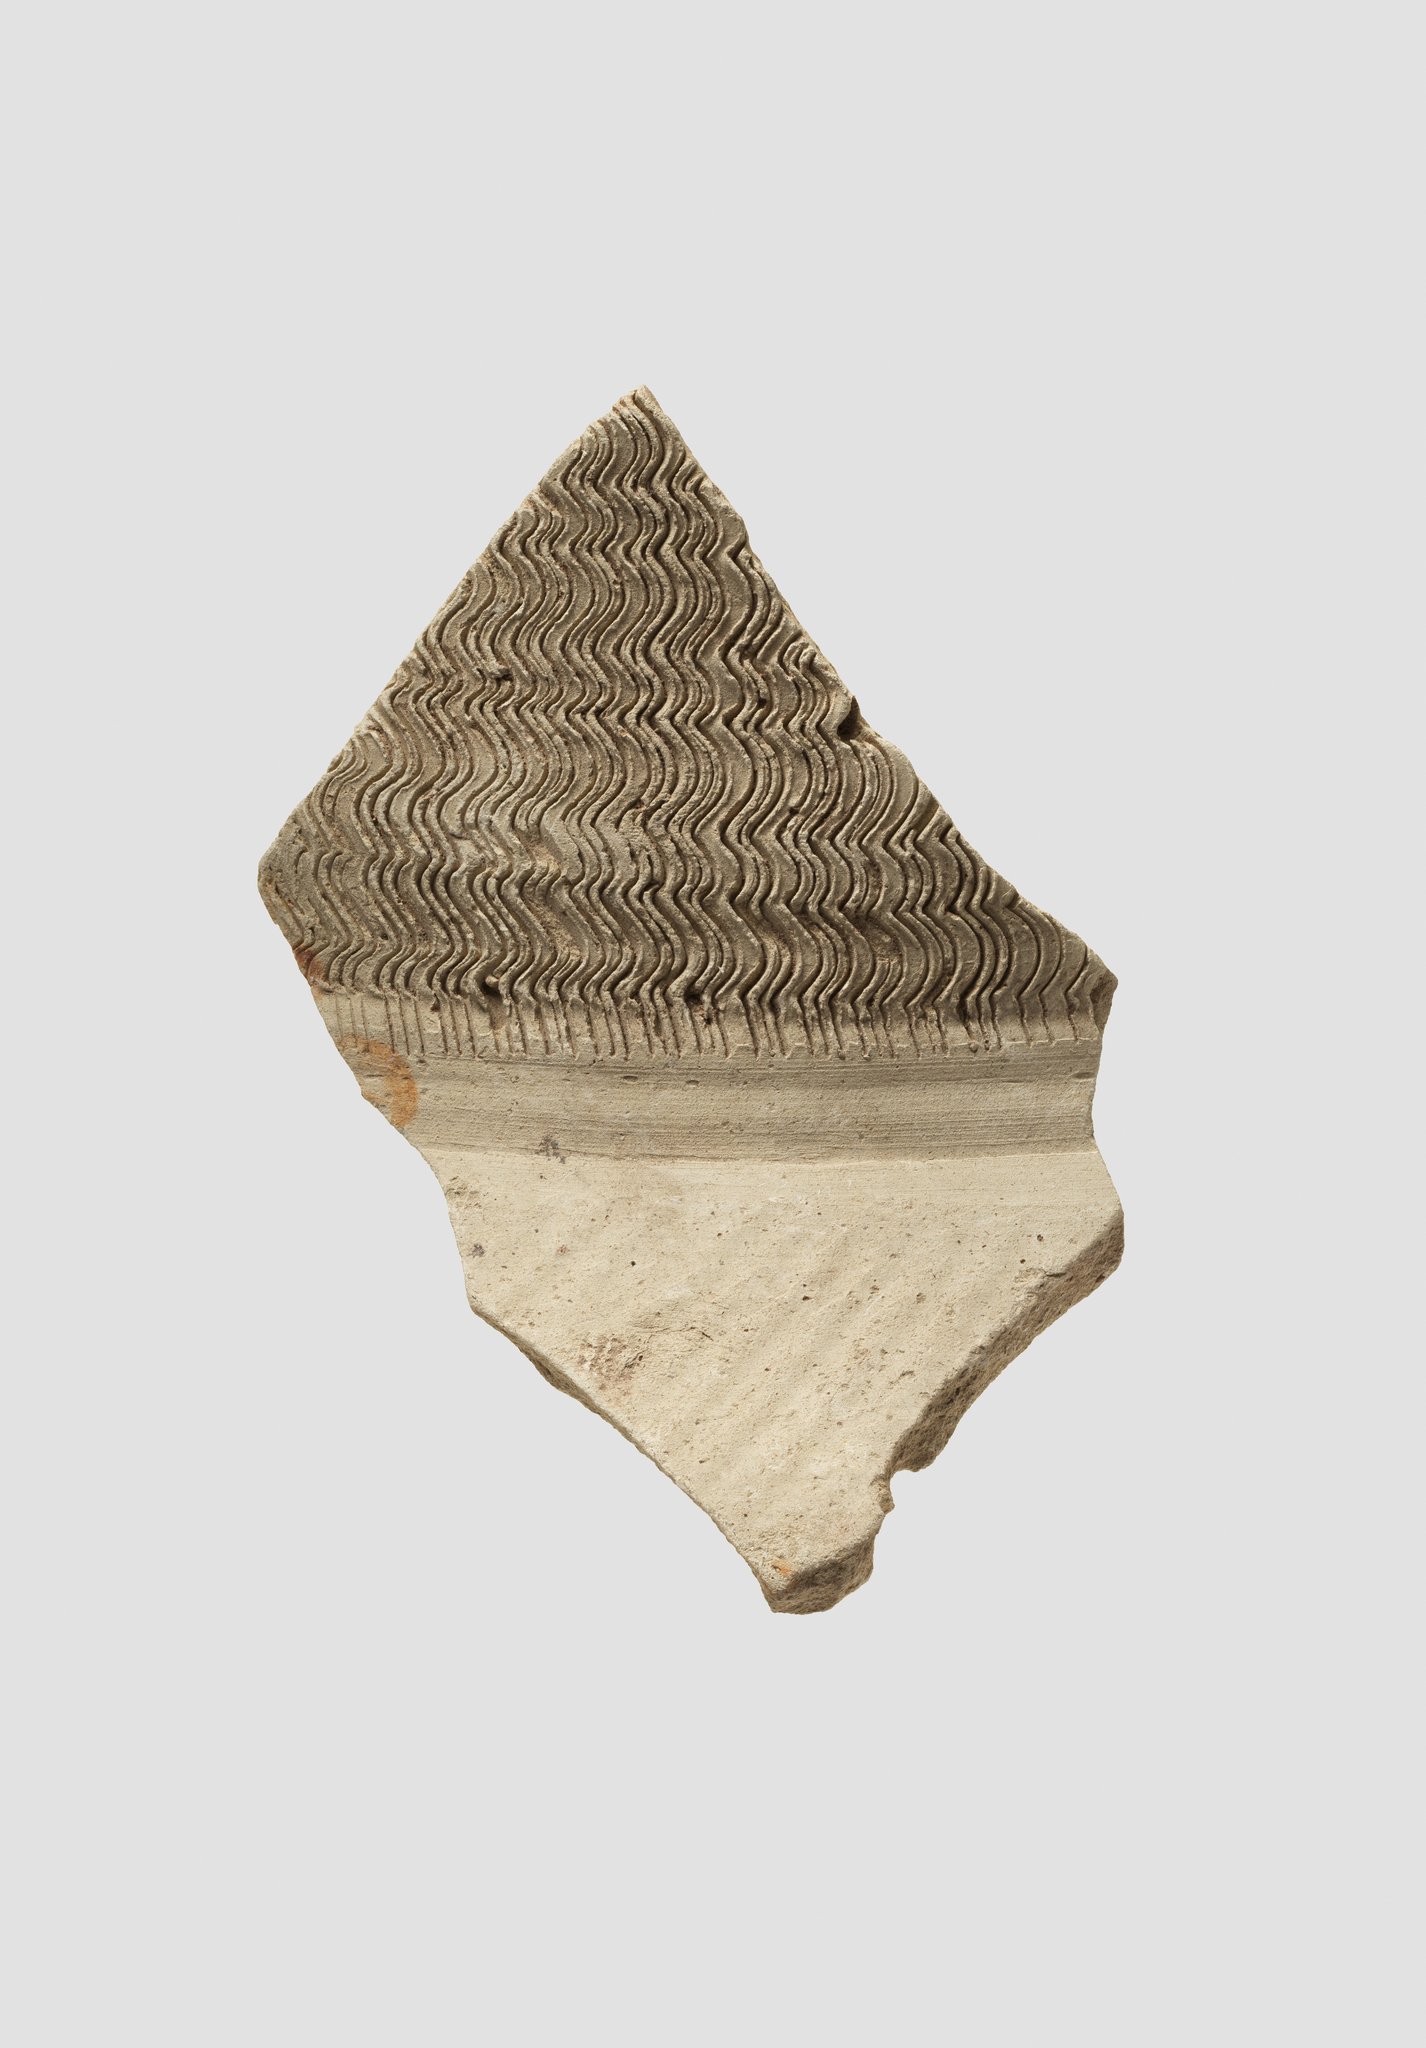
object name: sherd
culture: sasanian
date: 201-700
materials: ceramic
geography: mesopotamia